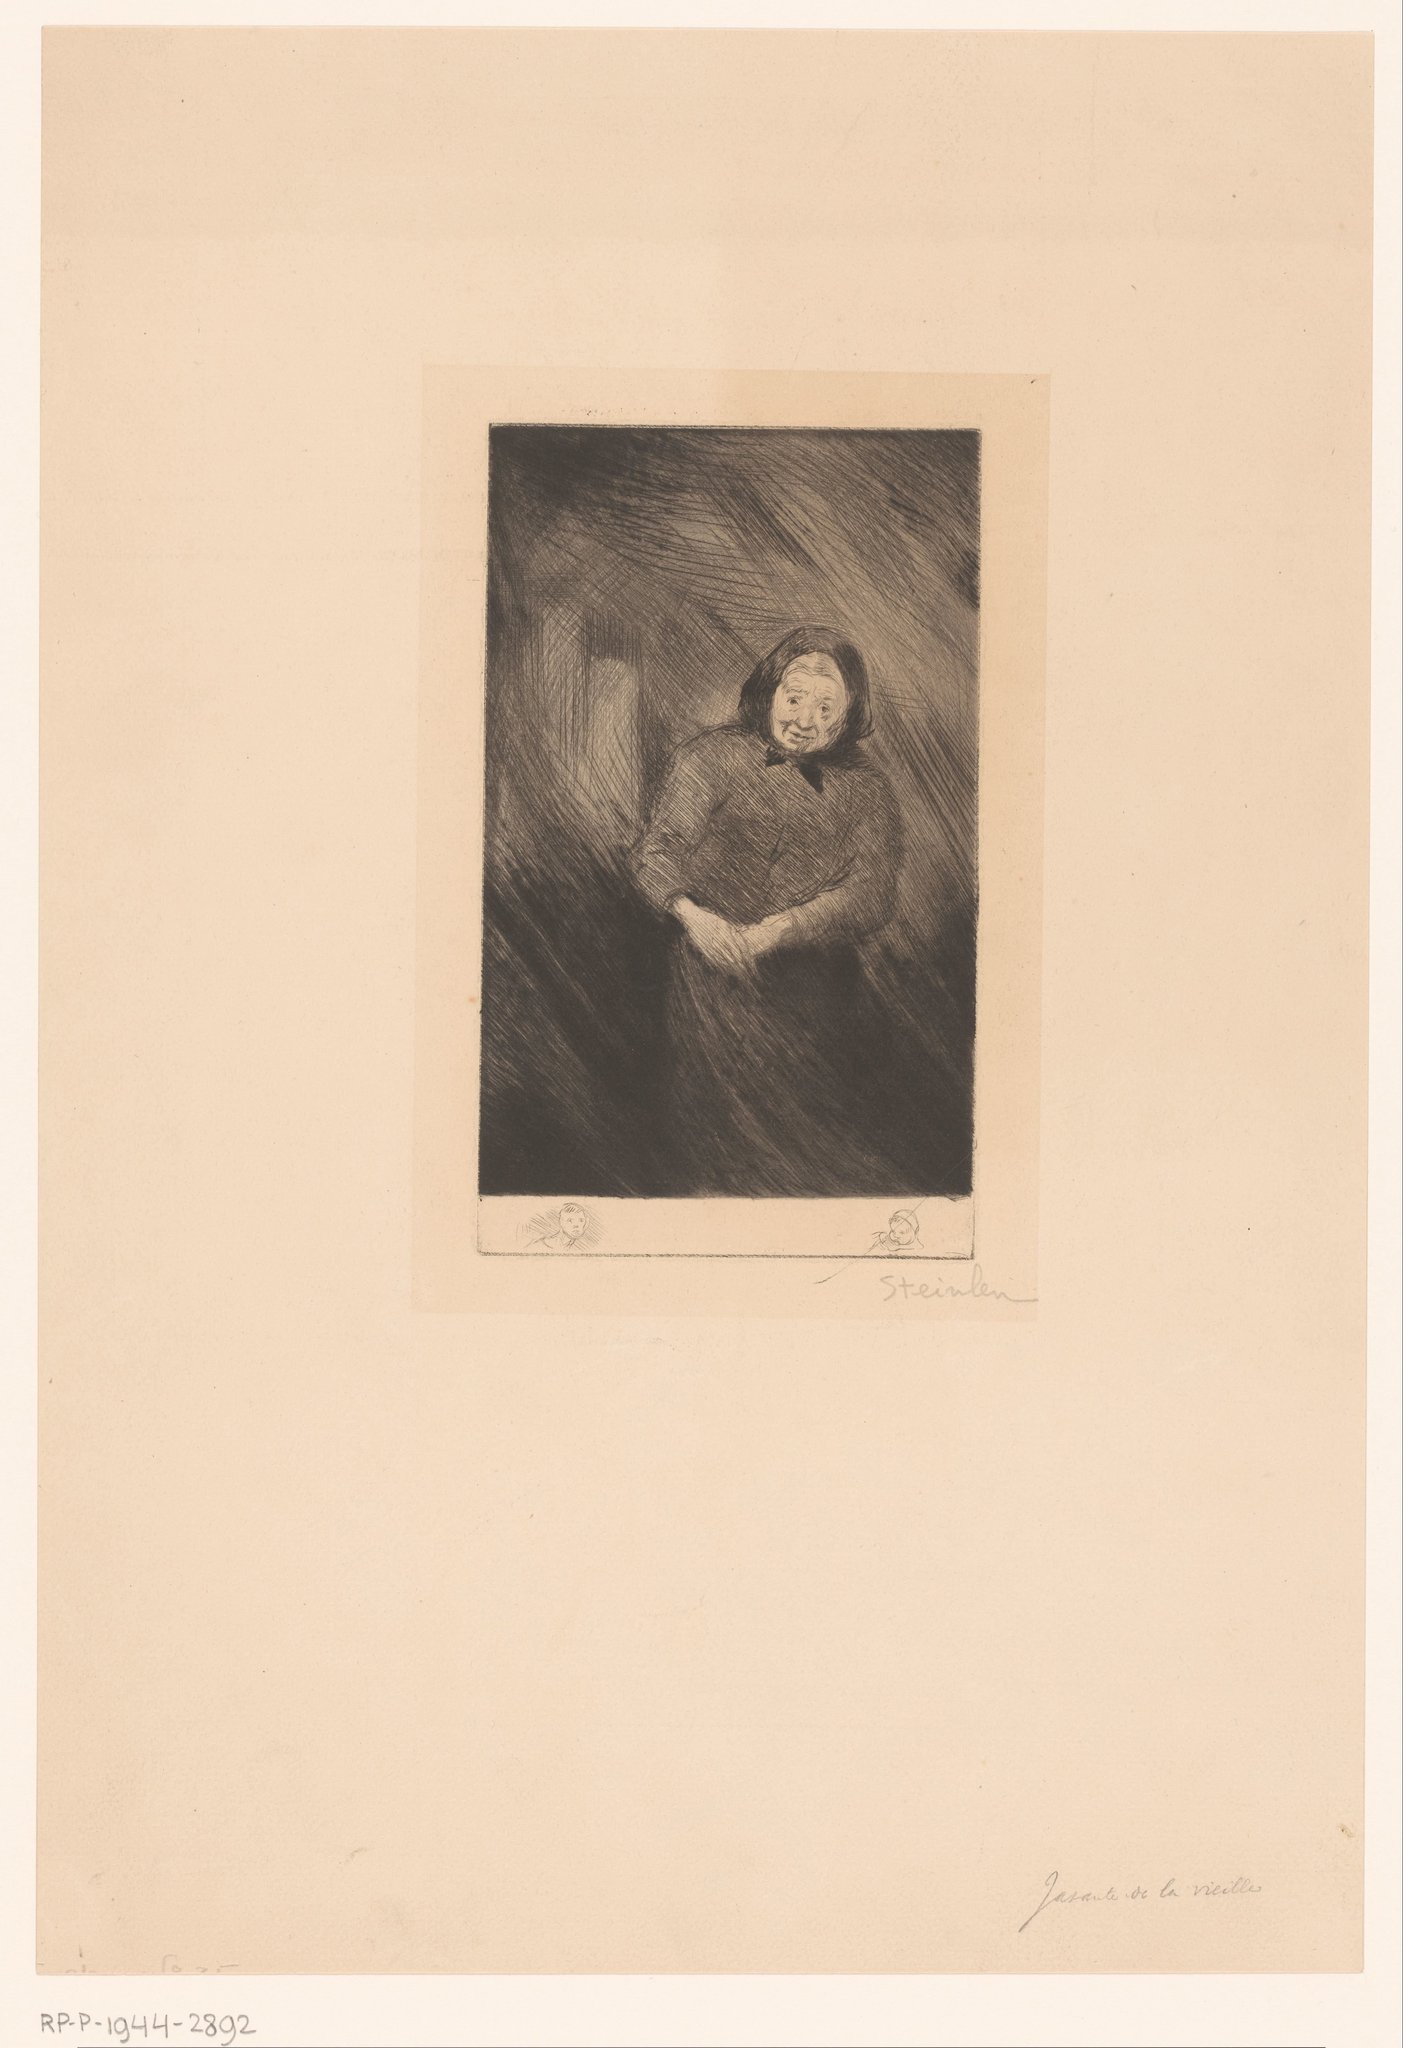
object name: print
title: Oude vrouw met hoofddoek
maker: théophile alexandre steinlen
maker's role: draughtsman, painter, print maker, sculptor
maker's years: 1859-1923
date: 1902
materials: paper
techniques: drypoint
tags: old woman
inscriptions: collector's mark: Lugt 2228, collector's mark: Lugt 2760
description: Onderin de marge twee schetsen van het hoofd van een man en een kind.